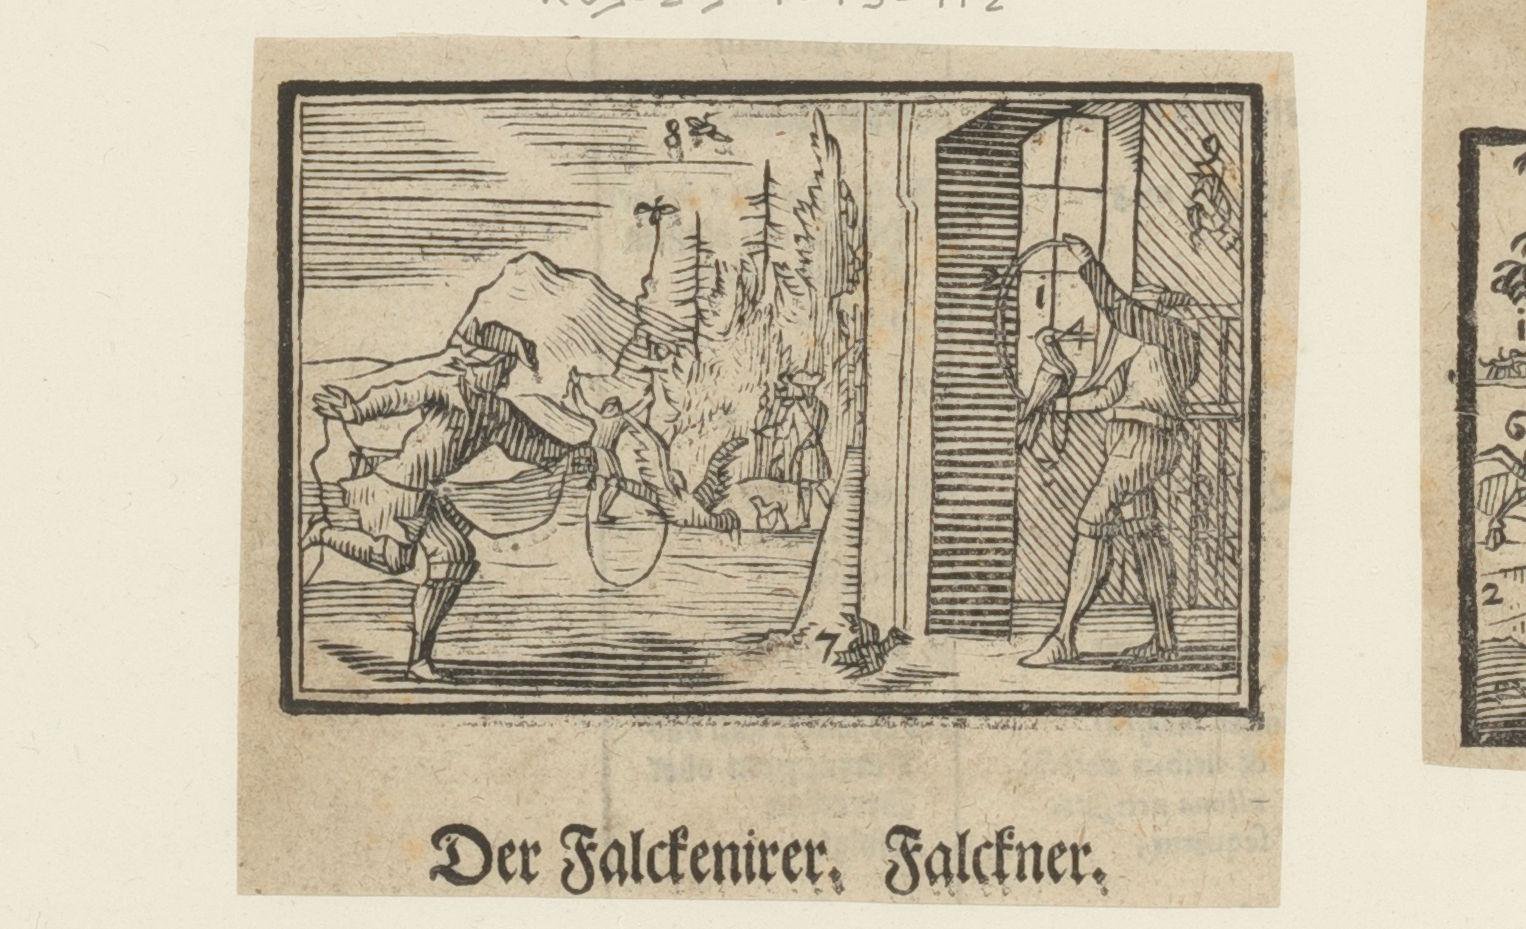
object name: book illustration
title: Der Falckenirer. Falckner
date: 1719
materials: paper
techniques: letterpress printing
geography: nuremberg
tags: predatory birds: falcon, hunting, chase, bird hunting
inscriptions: stamp, collector's mark: Lugt 1641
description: Het africhten van de valk. Rechts wordt een gevangen valk in een hoepel of ring gezet. De poten worden vastgebonden en de ogen afgedekt. Links wordt geoefend met een valk aan een touw. Onderwerpsrubrieken binnen de Atlas Zeden en Gewoonten: Handel, Nijverheid en Verkeer, Beroep en bedrijf, Complete suites.